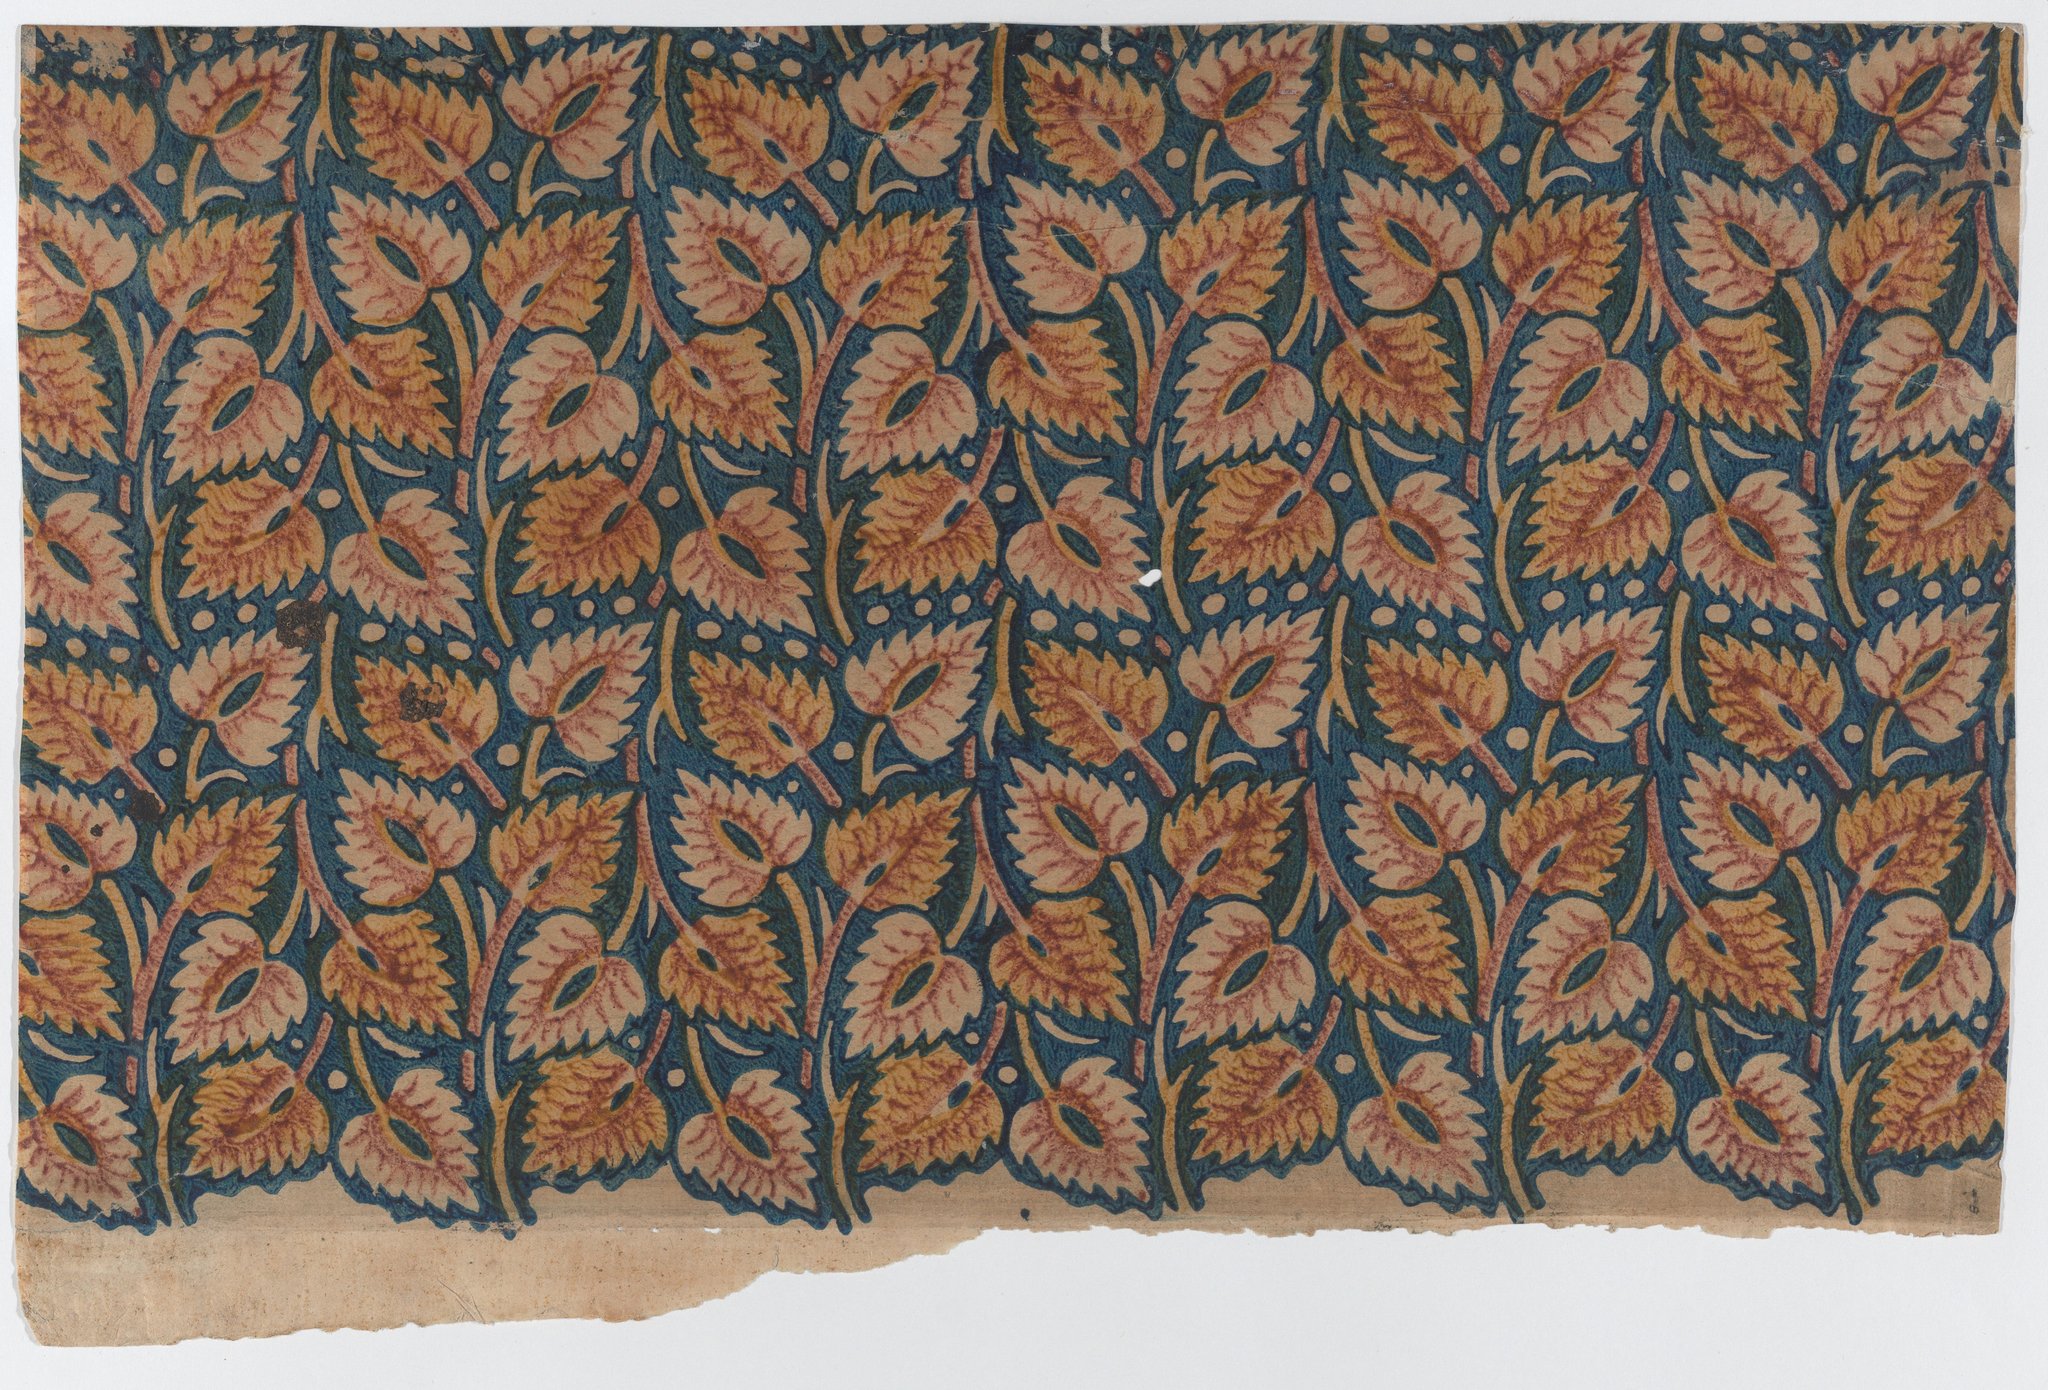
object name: print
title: Sheet with overall leaf pattern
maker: Anonymous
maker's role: artist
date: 1767-1866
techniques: relief print